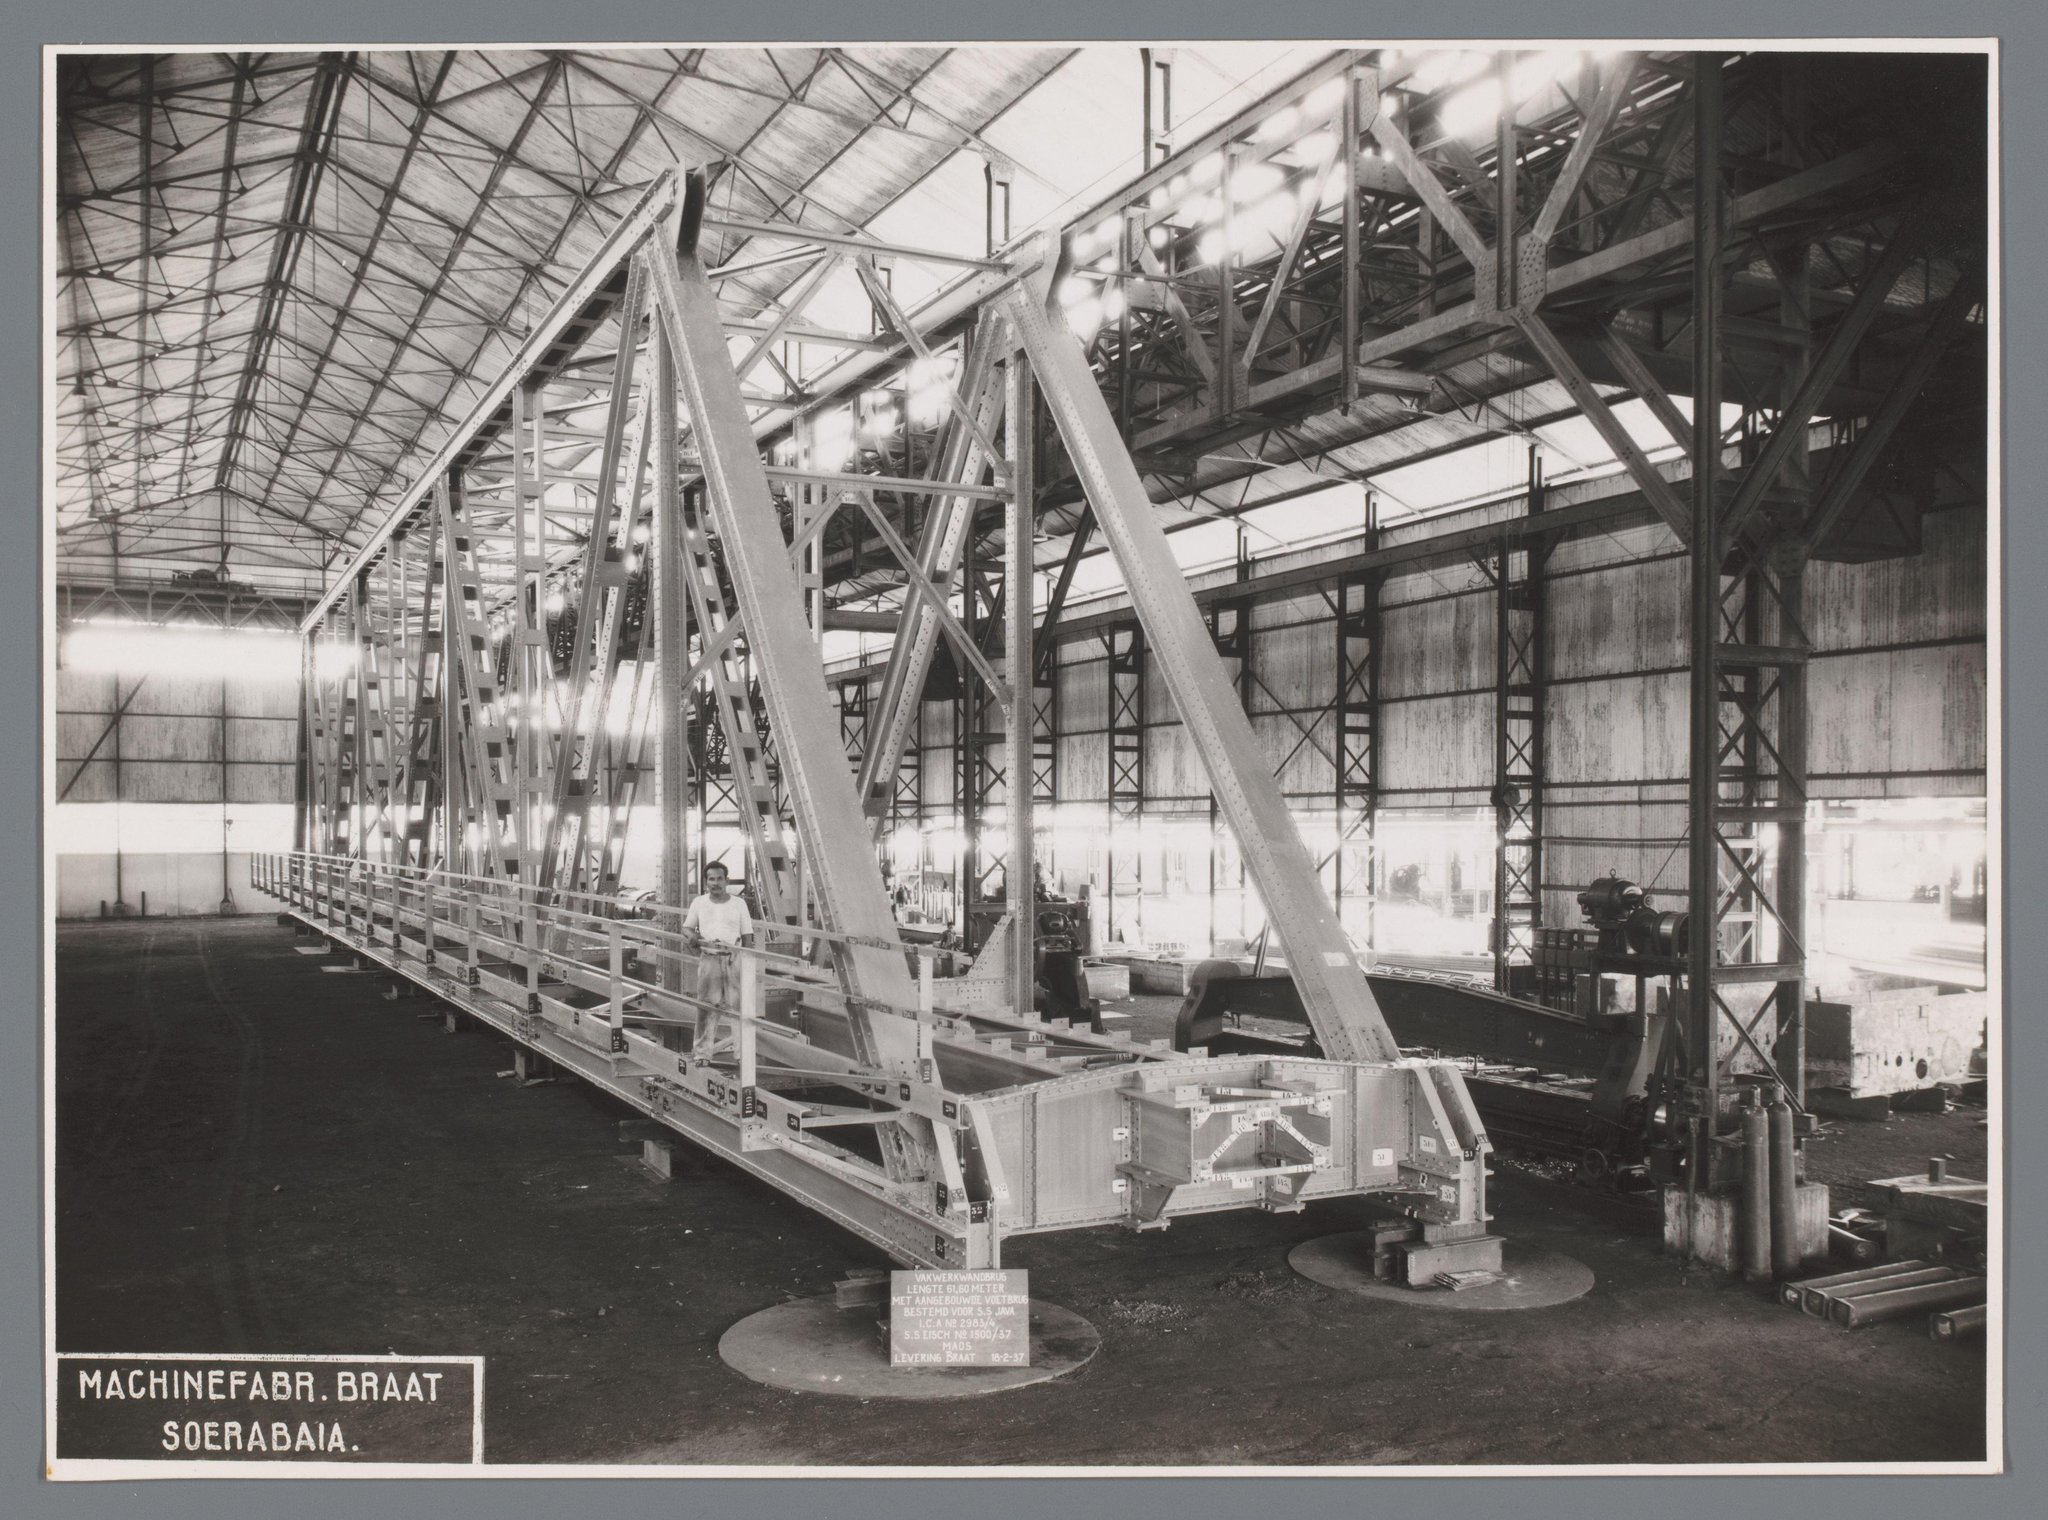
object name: photograph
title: Vakwerkwandbrug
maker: Anonymous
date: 1937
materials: photographic support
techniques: gelatin silver print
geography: surabaya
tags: colonial system, factory-interior, machine shop, machines; parts of machines; tools and appliances, bridge, java, dutch east indies, the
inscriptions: date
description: Een vakwerkwandbrug vervaardigd in 1937 en bestemd voor de dienst Staatsspoorwegen van de Indische Centrale Aanschaffingsdienst (I.C.A.). Onderdeel van de multomap met foto's van bruggen gebouwd door de N.V. Machinefabriek Braat te Soerabaja en bestemd voor verschillende plaatsen in Nederlands-Indië, uit de periode 1931-1940.